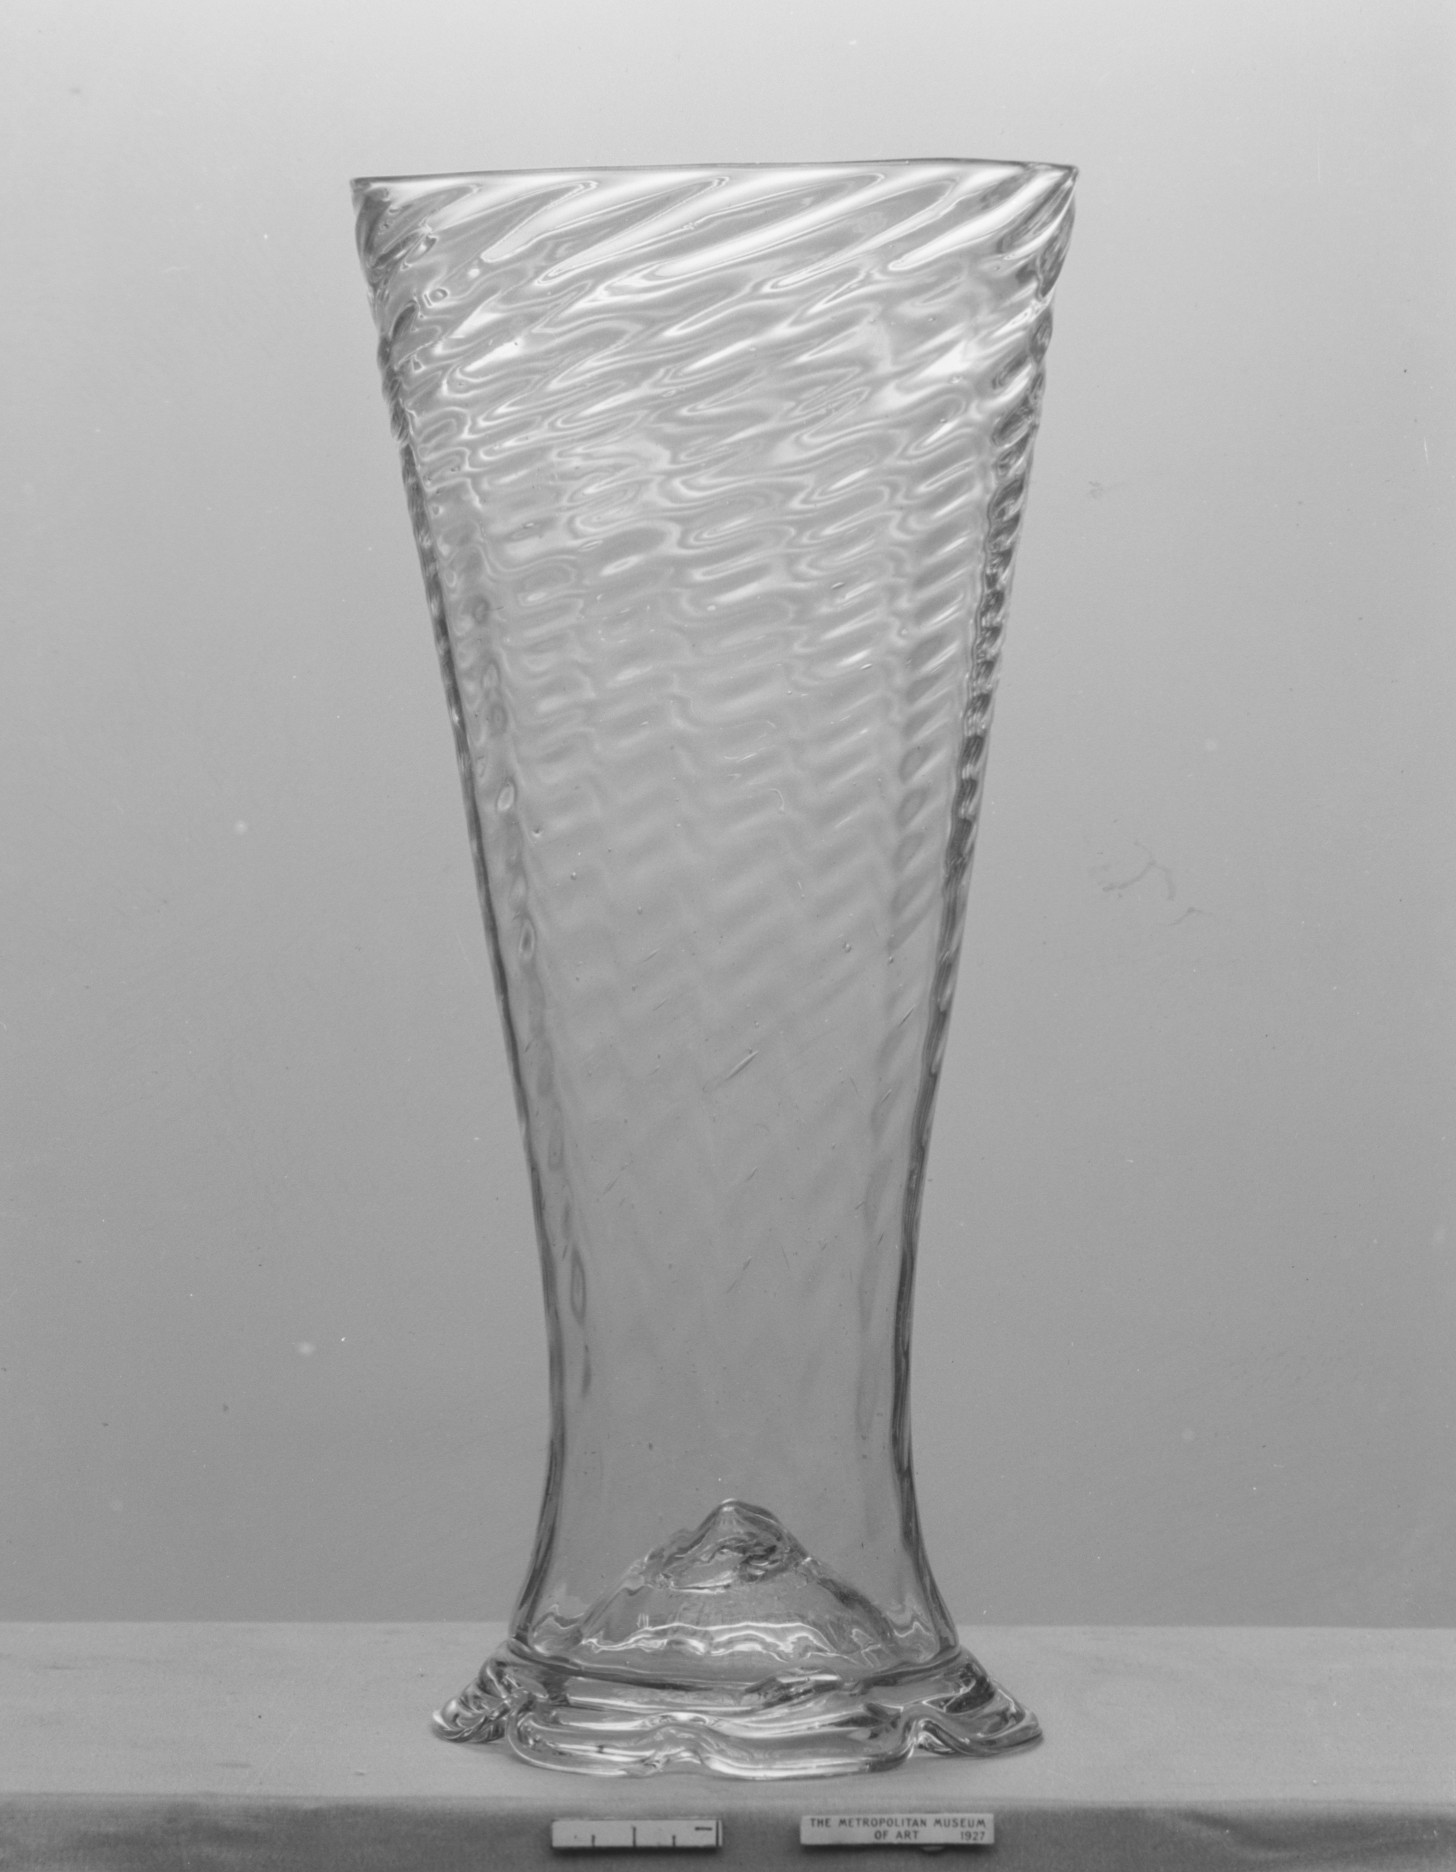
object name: beaker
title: Beaker (Humpen)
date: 1601-1700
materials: glass